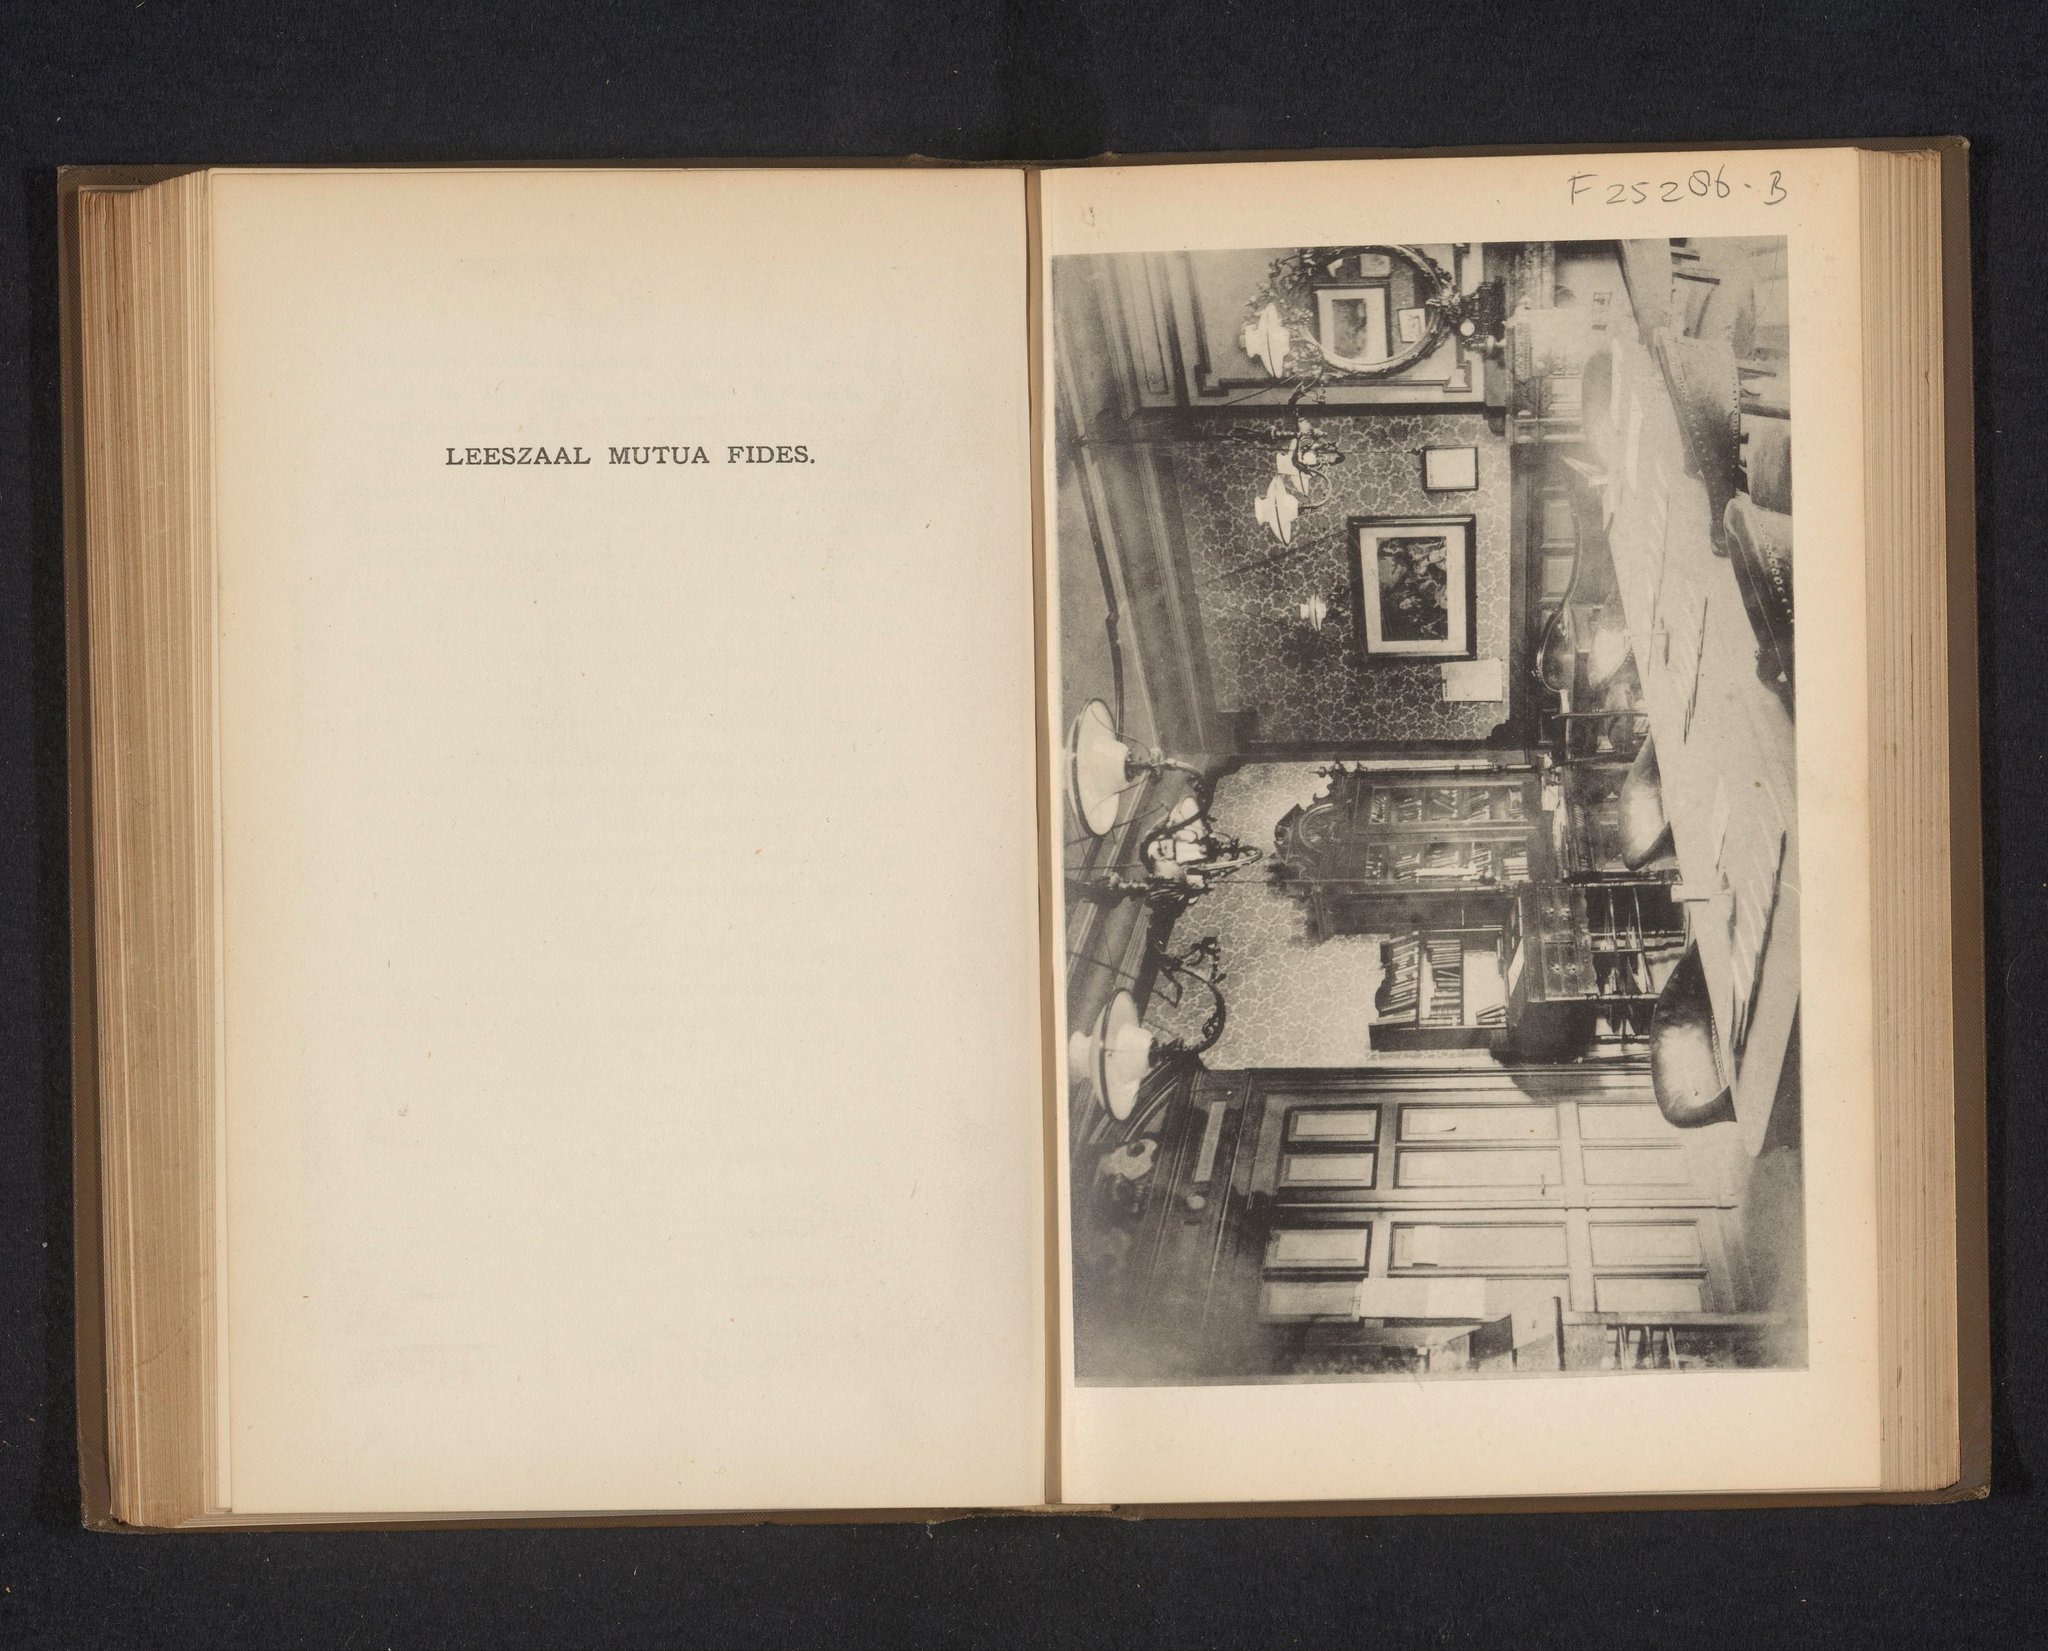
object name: page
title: Gezicht op de leeszaal van studentensociëteit Mutua Fides in Groningen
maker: Anonymous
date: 1893-1898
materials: paper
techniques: photograph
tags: students' organization, communal rooms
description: Prent op derde ongenummerde pagina na pagina 174.